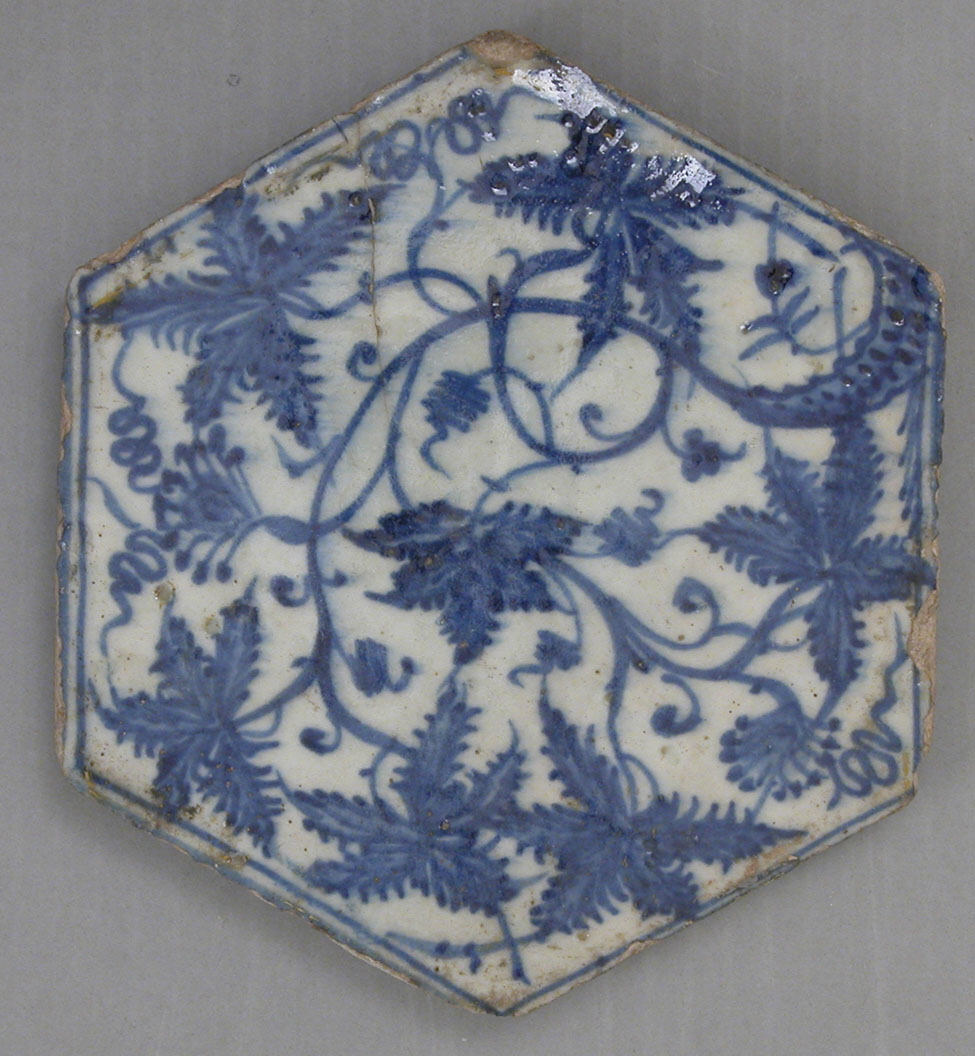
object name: hexagonal tile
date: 1401-1500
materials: stonepaste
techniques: painting, underglaze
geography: egypt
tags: leaves